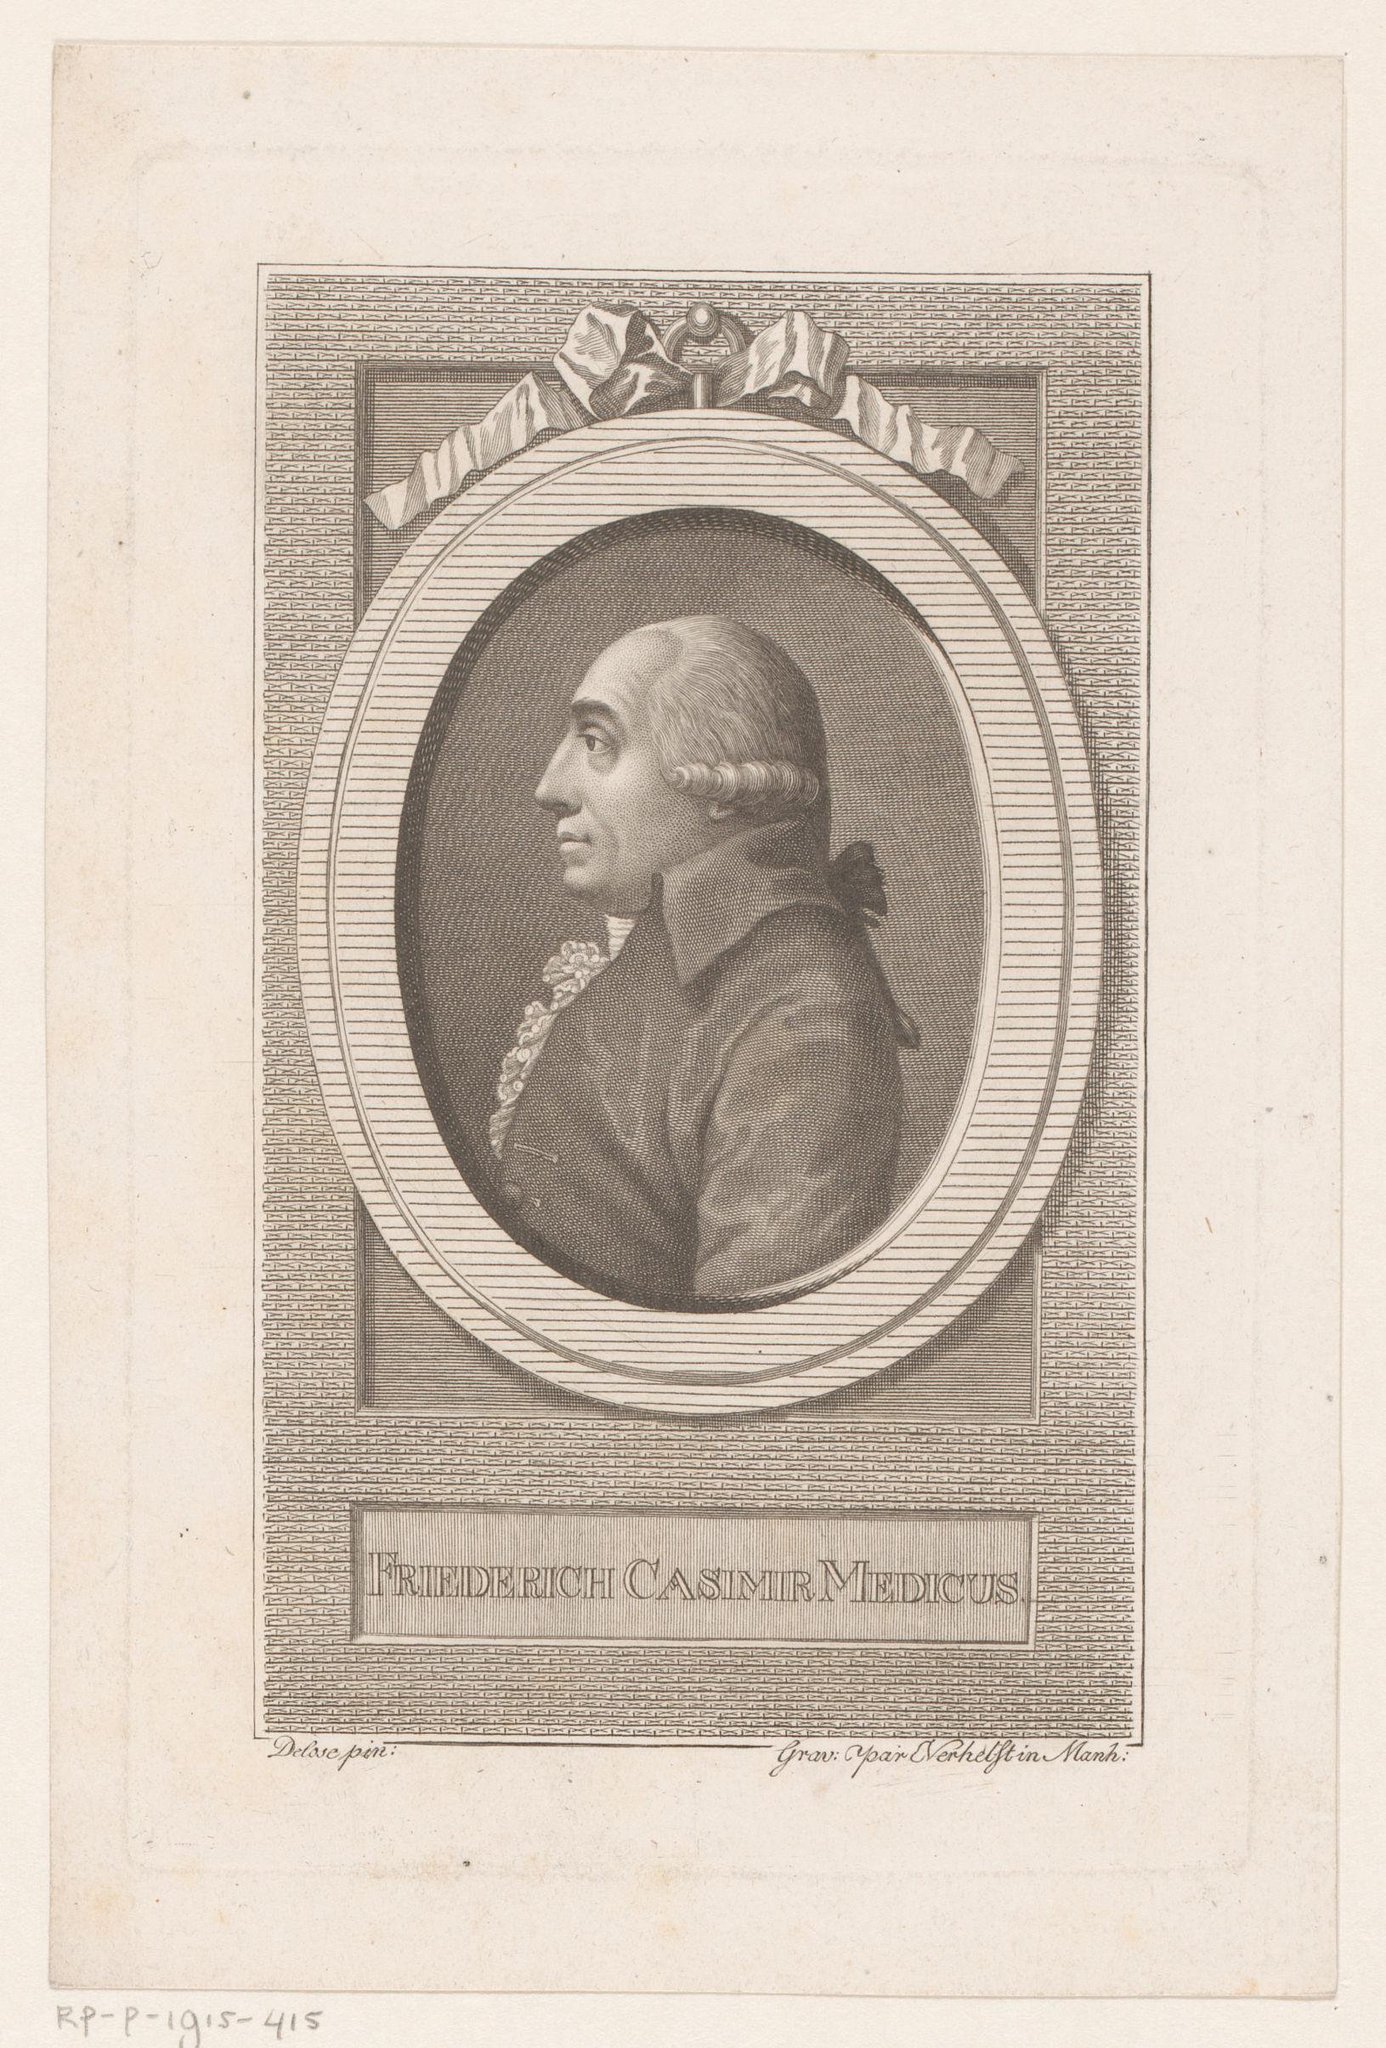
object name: print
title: Portret van Friedrich Casimir Medicus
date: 1765-1818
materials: paper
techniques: engraving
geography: mannheim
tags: historical persons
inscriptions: collector's mark: Lugt 2233